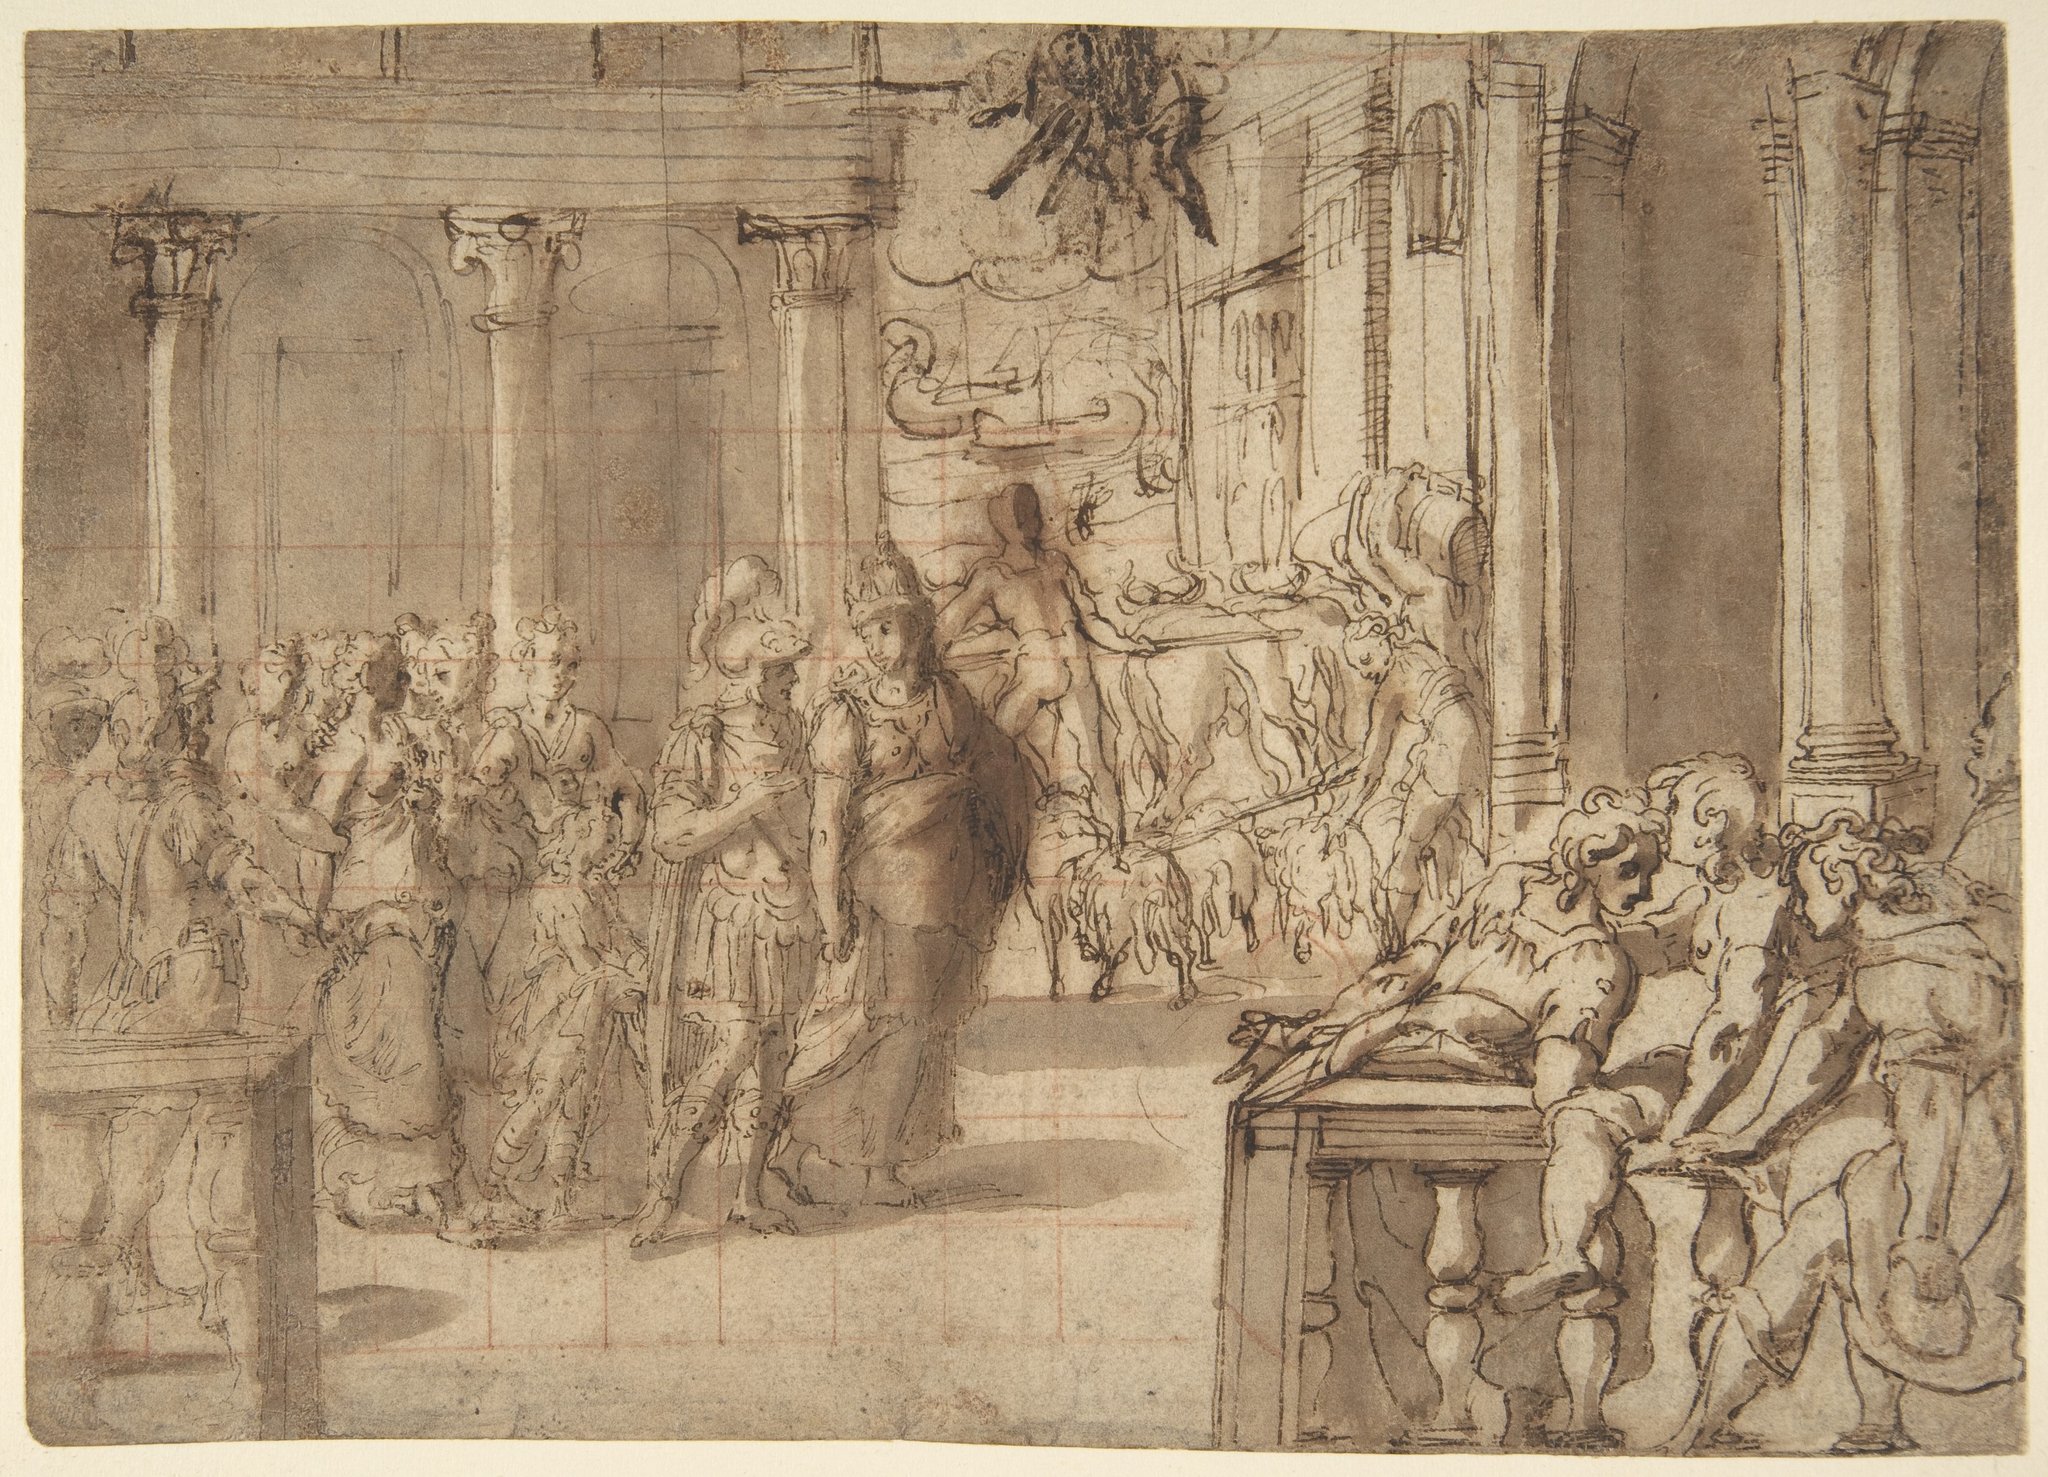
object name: drawing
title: Dido and Aeneas (recto); Three Figures Traced in Reverse from Recto and a Study of a Seated Man (verso)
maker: anonymous, italian, 16th century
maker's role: artist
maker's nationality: italian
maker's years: 1550-1600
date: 1501-1600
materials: graphite, ink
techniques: brush, pen, drawing, transfer, wash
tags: aeneas,crowd